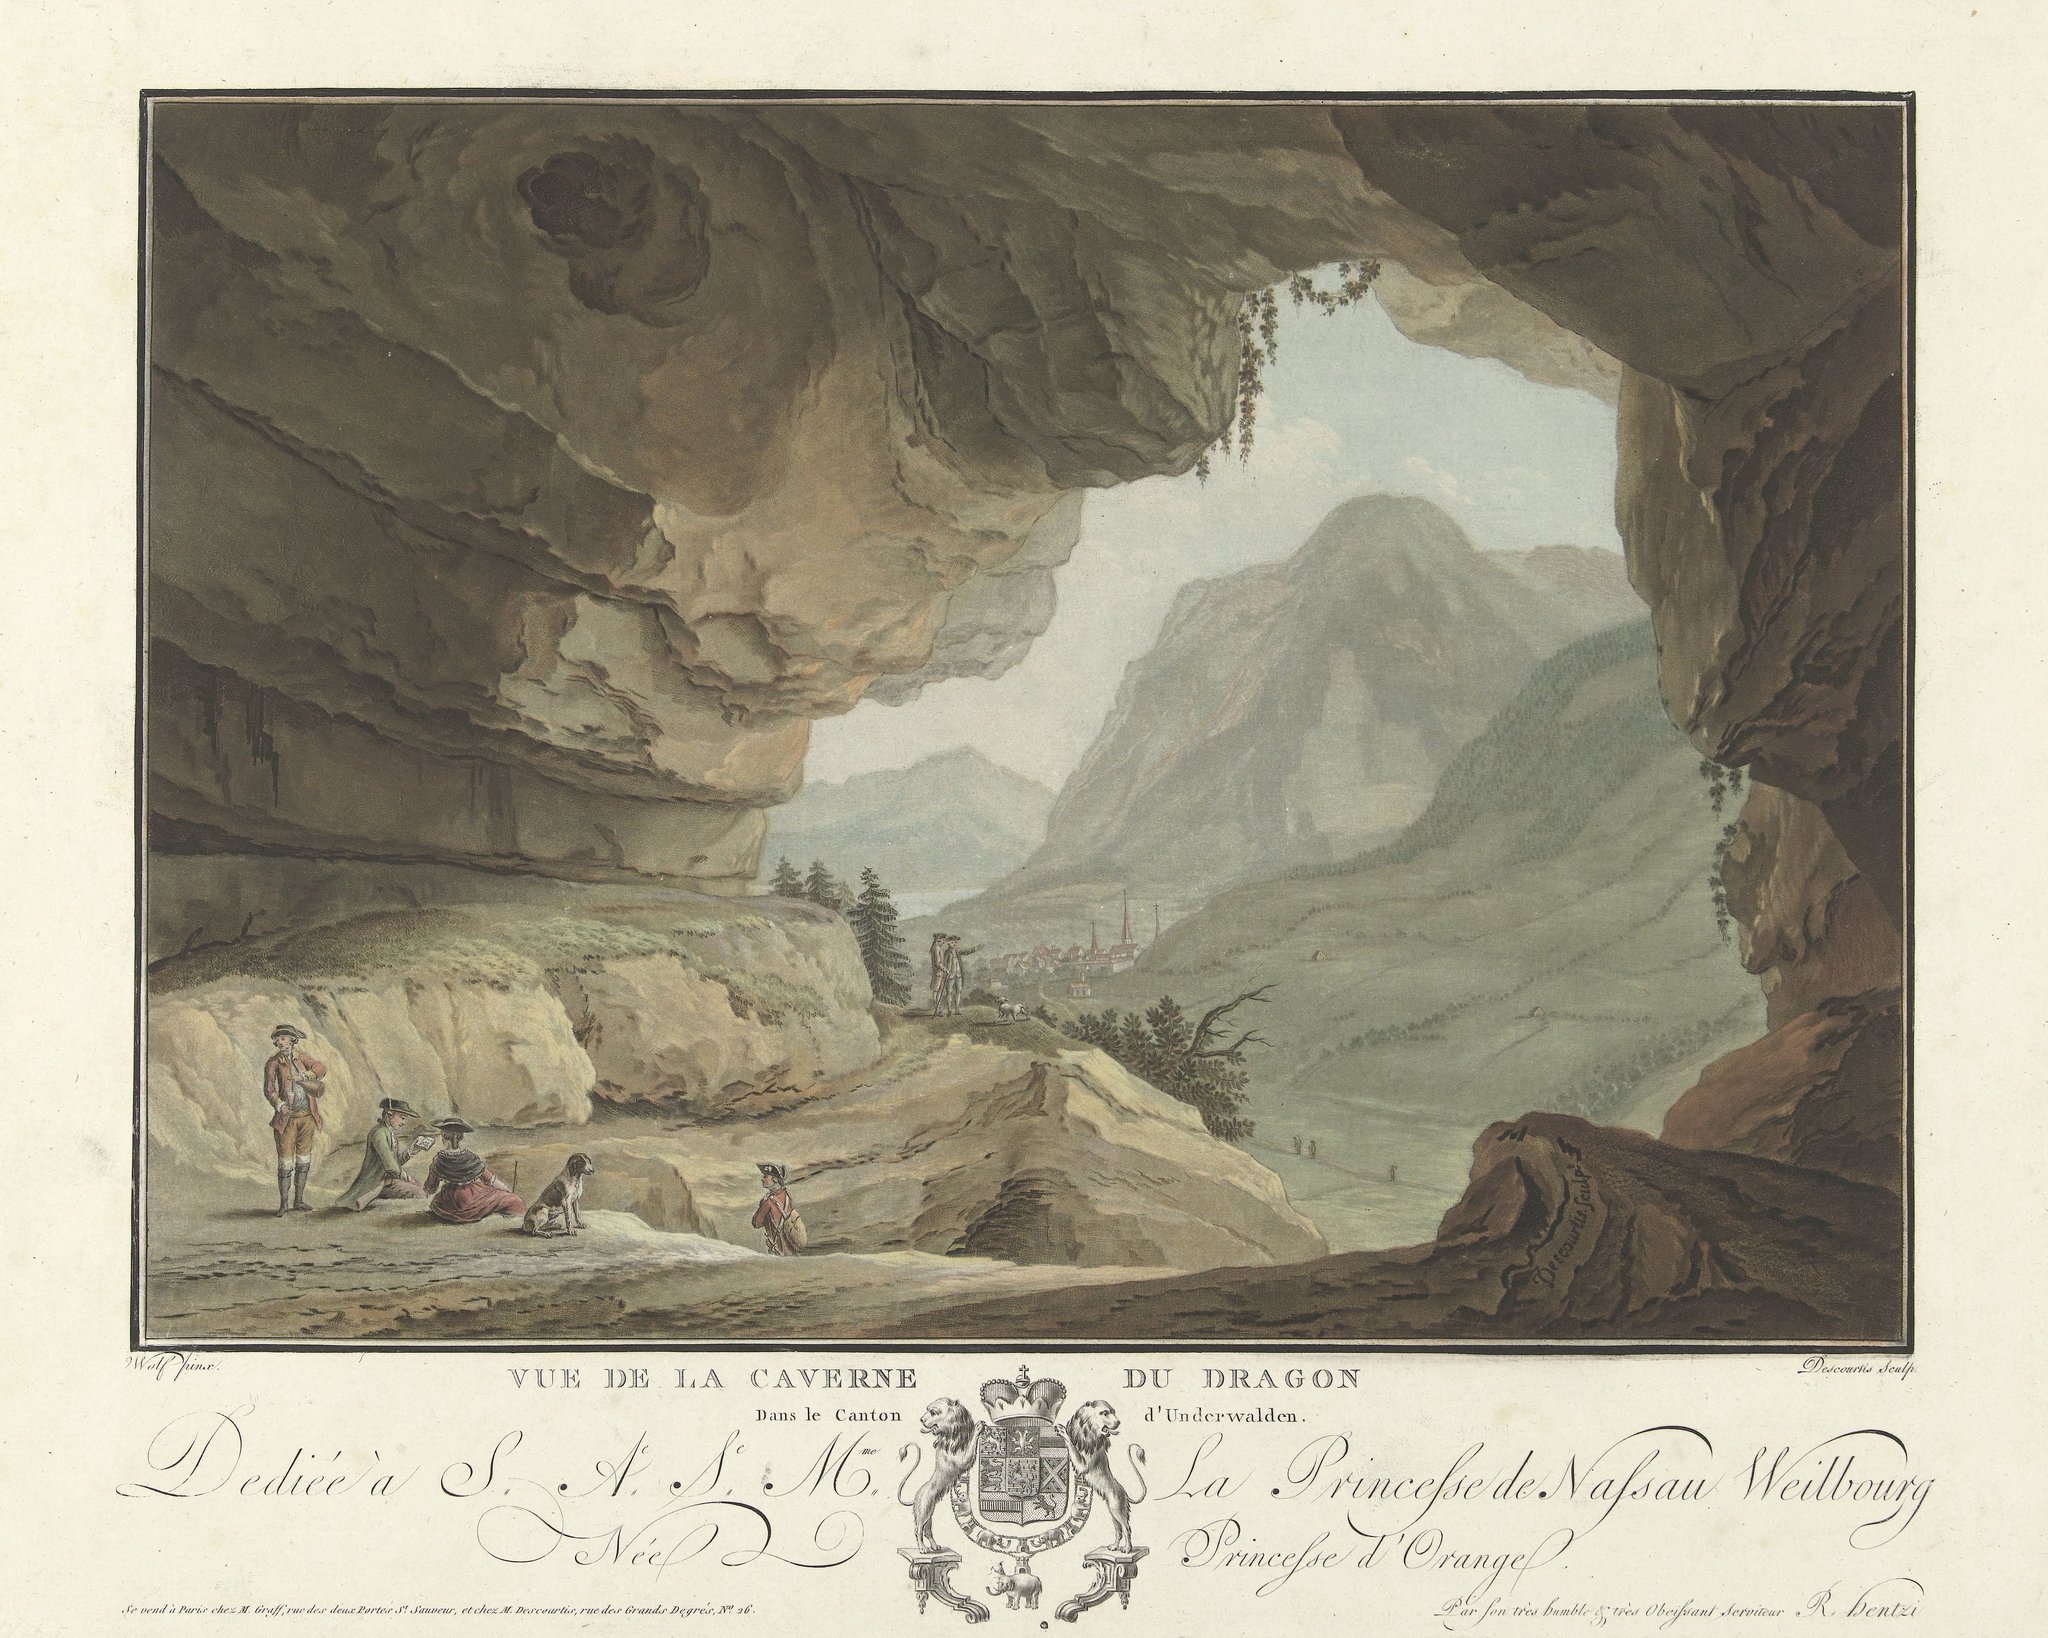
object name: print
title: Vue de la Caverne du Dragon dans le Canton d' Underwalden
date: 1763-1820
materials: paper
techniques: etching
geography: paris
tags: cave, grotto, outing, pleasure trip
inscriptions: inscription: ‘Hentz’, collector's mark: Lugt 2228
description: Gezicht vanuit een grot in Unterwalden in Zwitserland. Drie heren, een dame en een hond rusten uit in de grot. Op het tweede plan twee heren die naar het dal wijzen. Onder de voorstelling tekst en een wapenschild van Carolina van Nassau-Weilburg.